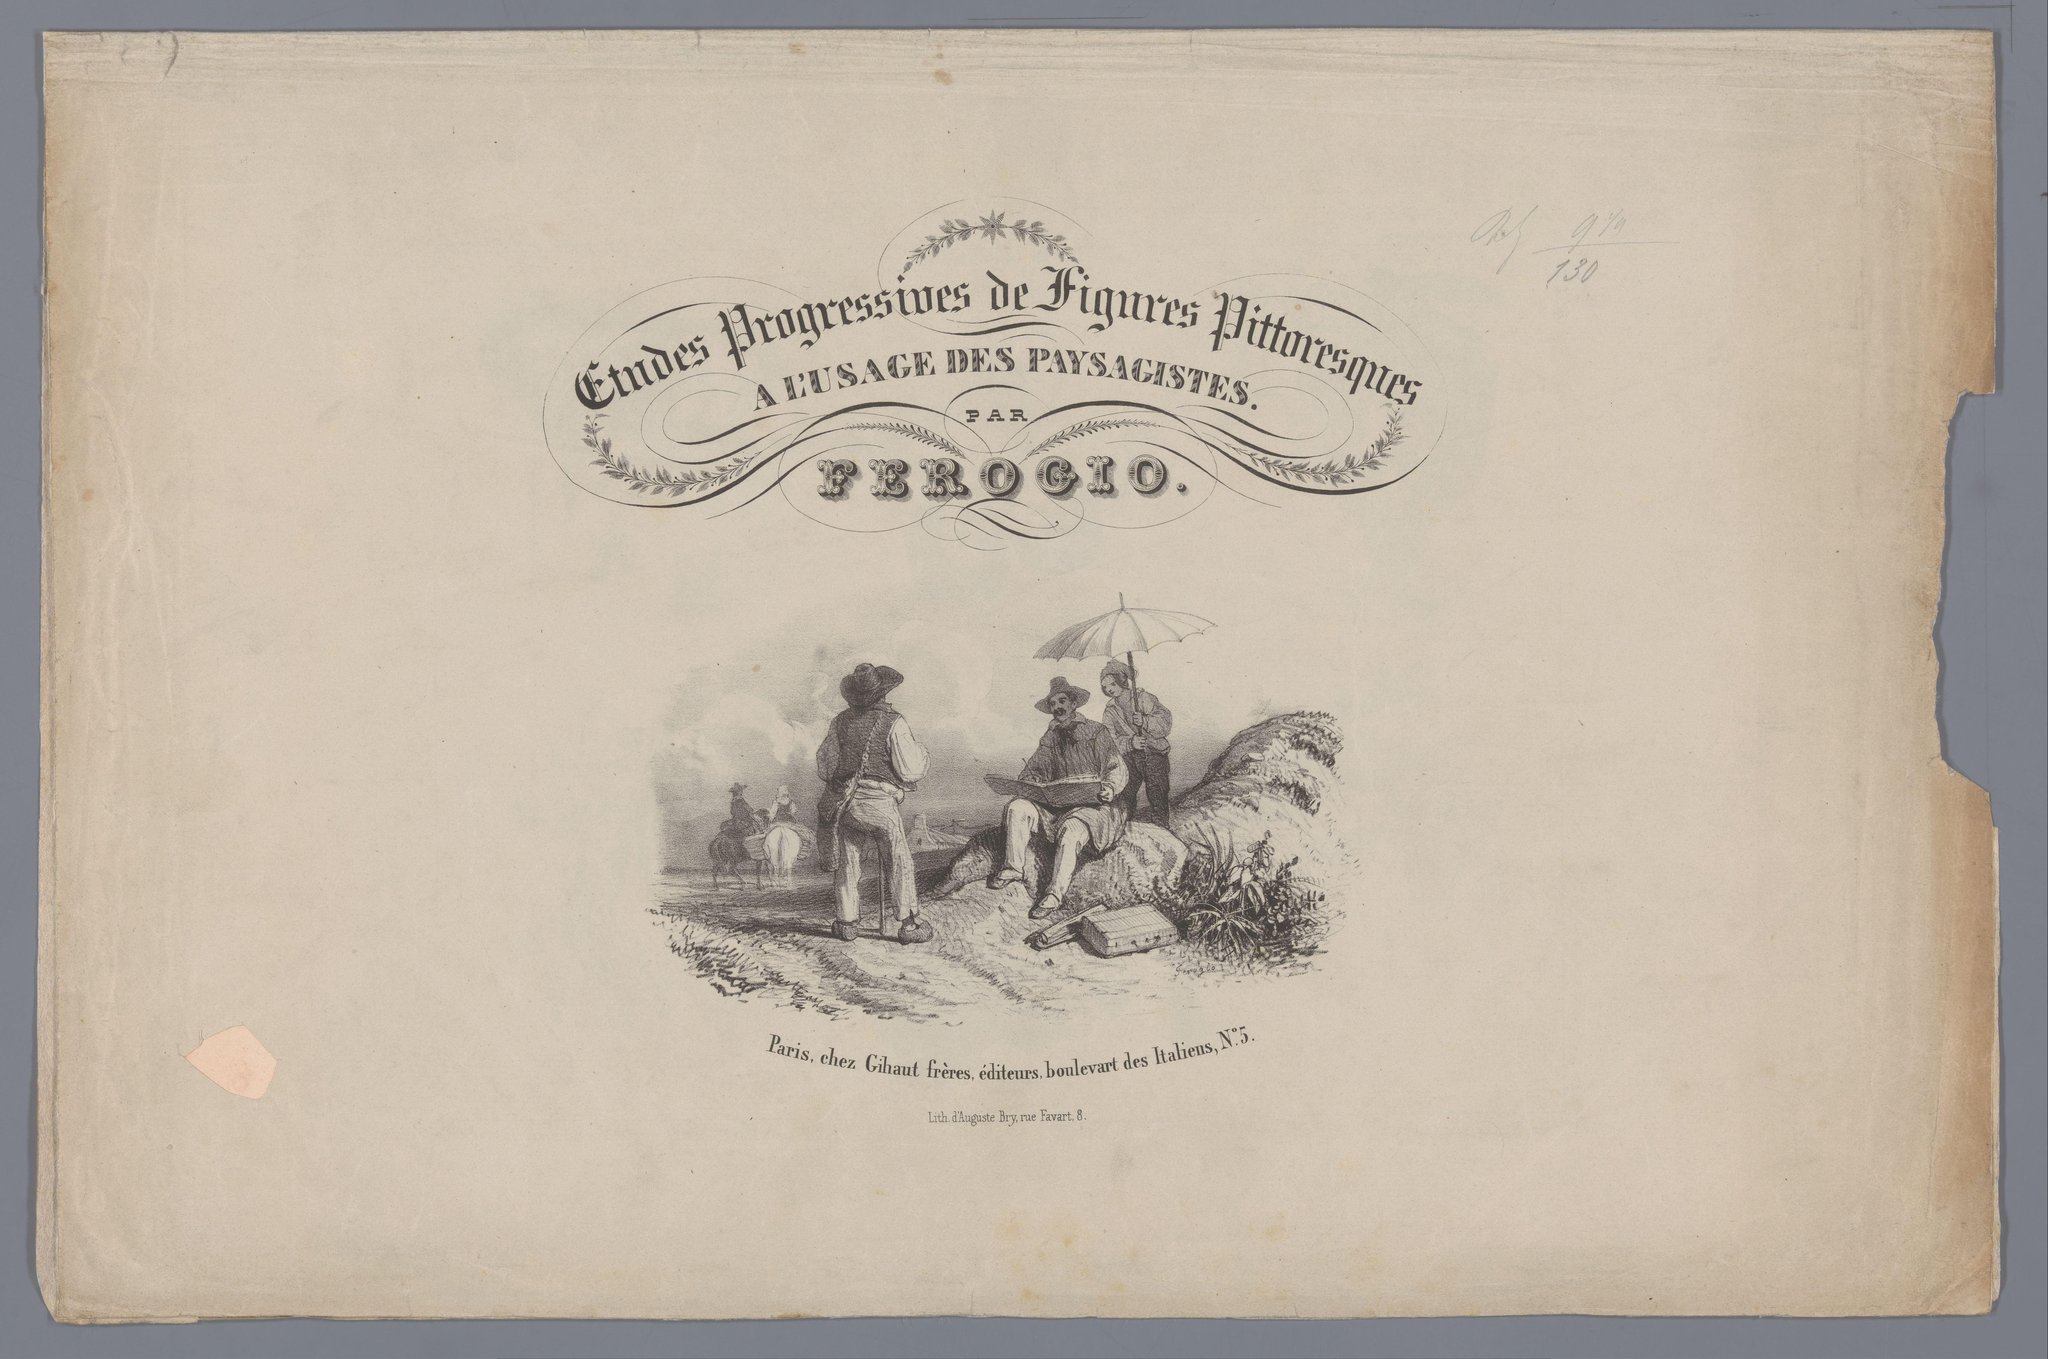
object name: print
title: Voorbeelden van figuurstudies voor landschapskunstenaars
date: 1839-1846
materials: paper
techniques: lithograph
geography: paris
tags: draughtsman at work - cc - out of doors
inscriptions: collector's mark: Lugt 2228a